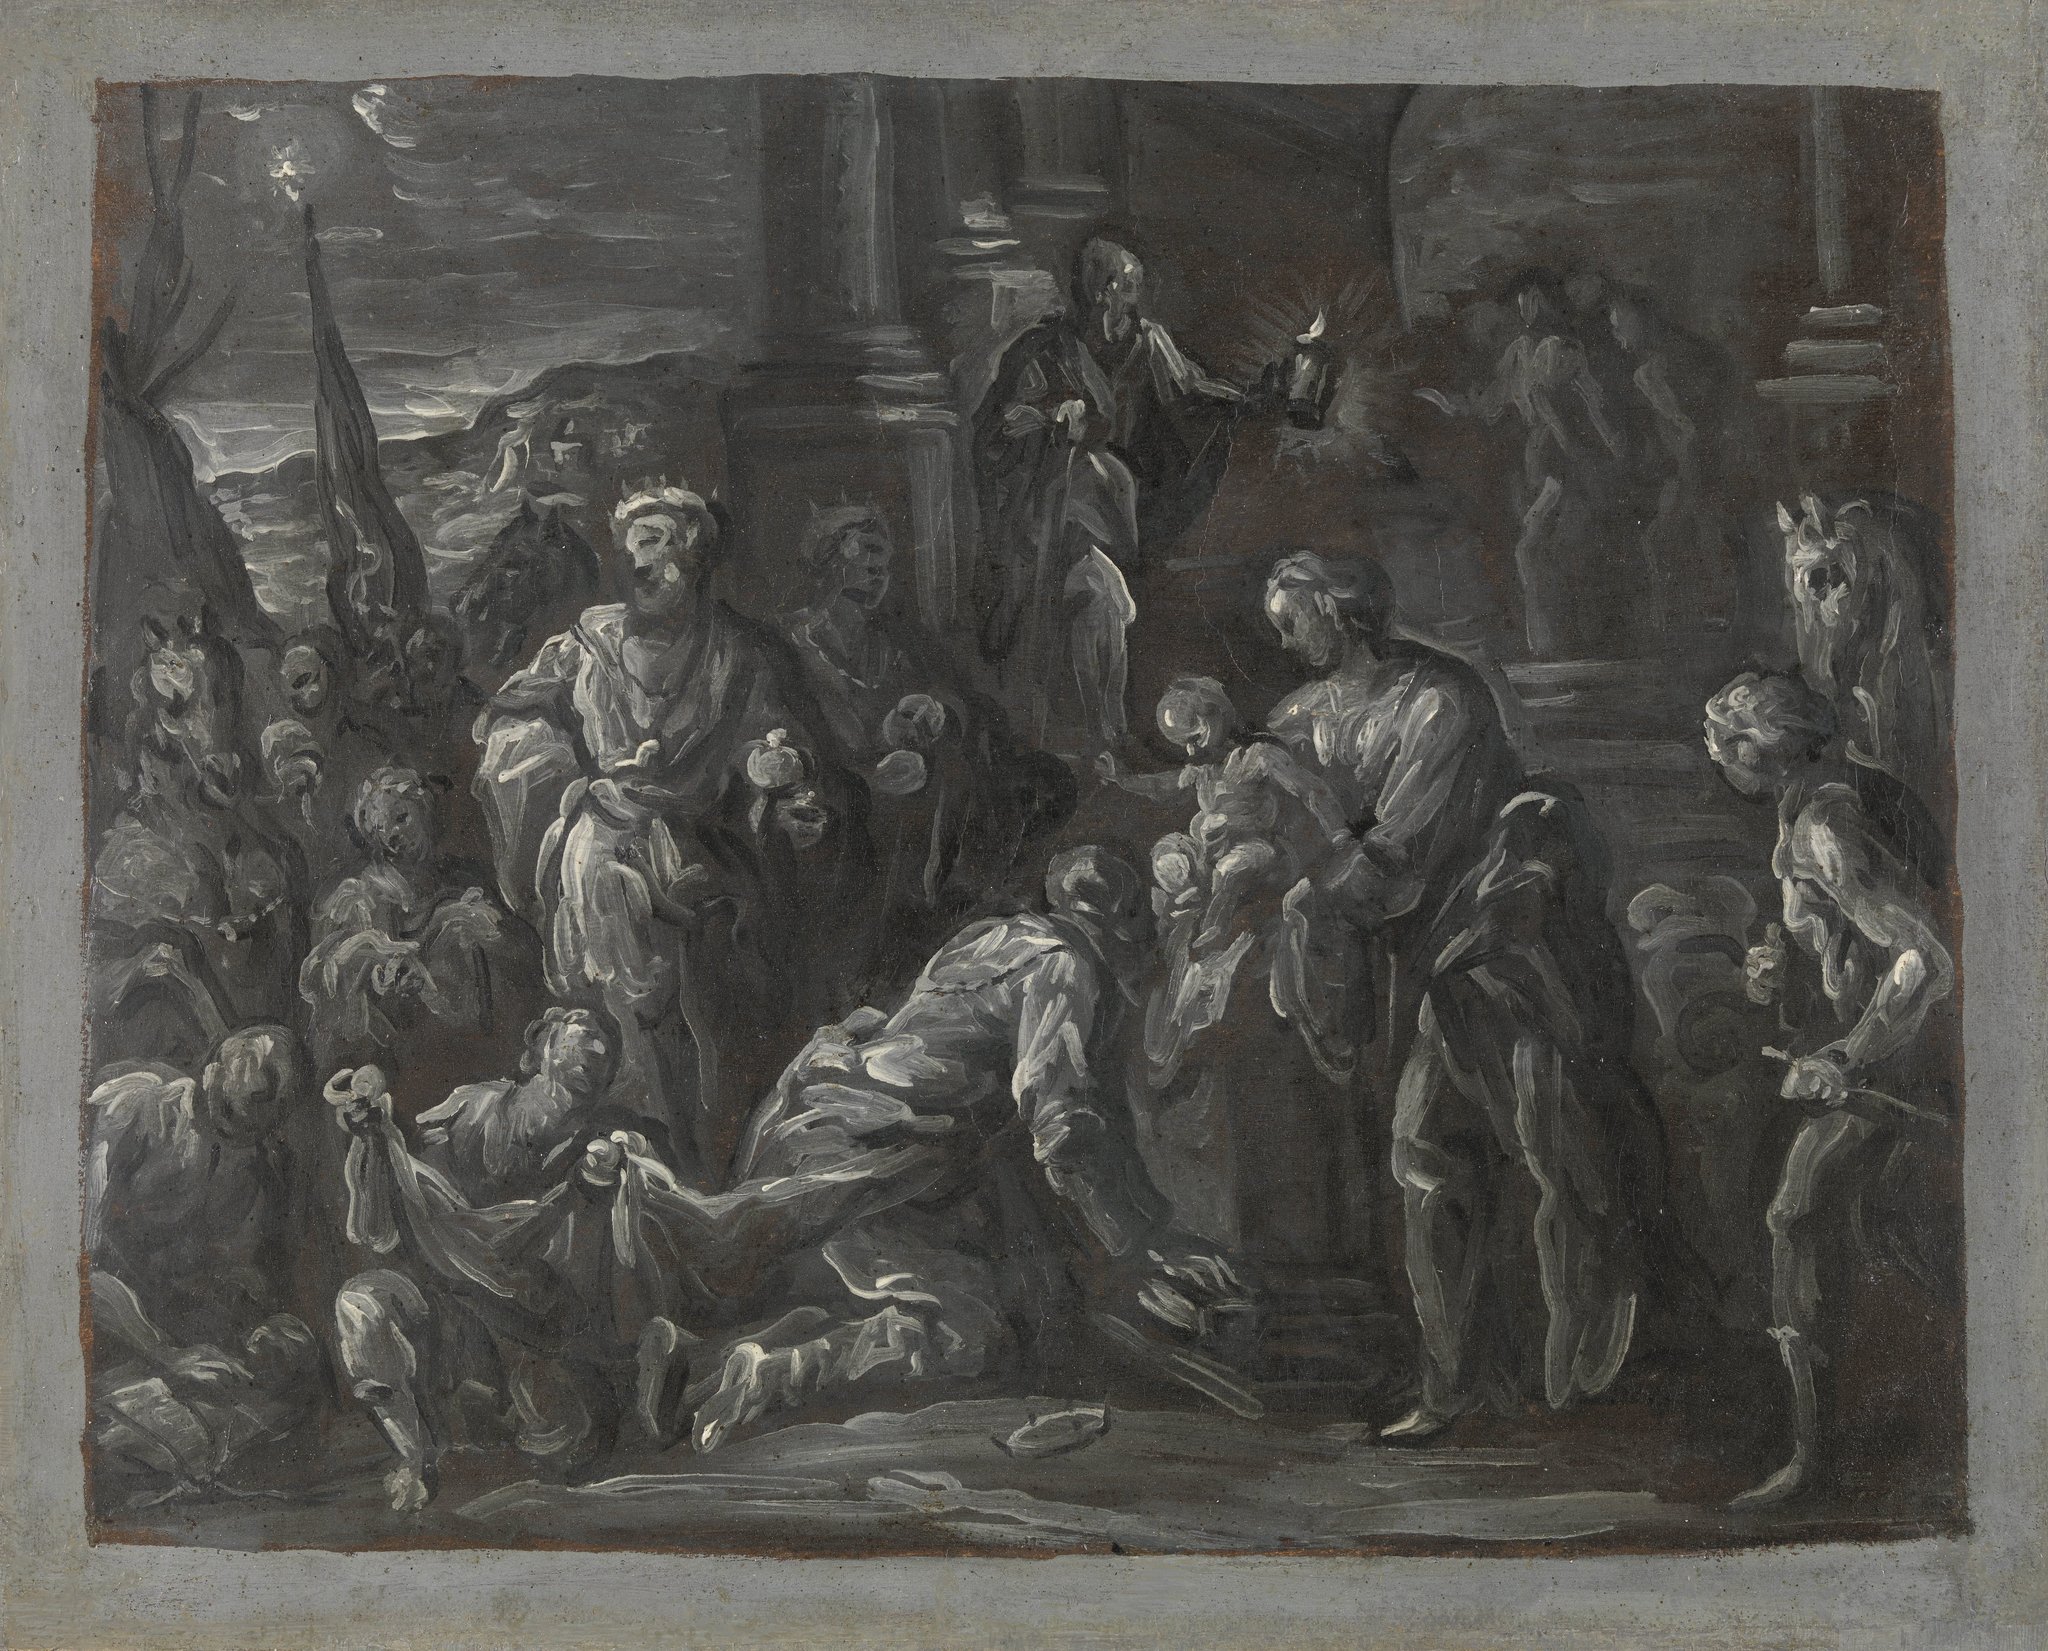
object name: oil sketch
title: De Aanbidding der Koningen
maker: andrea michieli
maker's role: painter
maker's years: 1539-1614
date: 1575-1599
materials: linen, oil, paper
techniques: brush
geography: venice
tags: adoration of the kings: the wise men present their gifts to the christ-child (gold, frankincense and myrrh)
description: The artist’s nickname comes from his birthplace, Vicenza near Venice. Following the example of Late Renaissance Venetian masters such as Tintoretto and Veronese, Vicentino sketched some compositions directly in oil, with apparent ease. During the 16th century, this particular talent, called sprezzatura, was praised as the expression of true artistic genius. Here, the monochrome technique perfectly conveys the candlelit nocturnal scene.